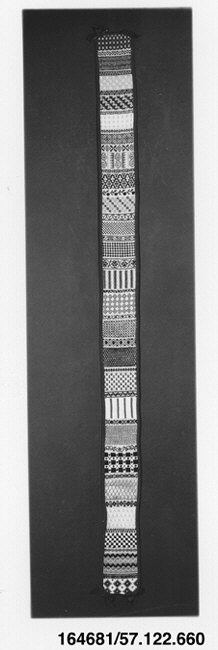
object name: sampler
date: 1801-1900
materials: canvas, silk, wool